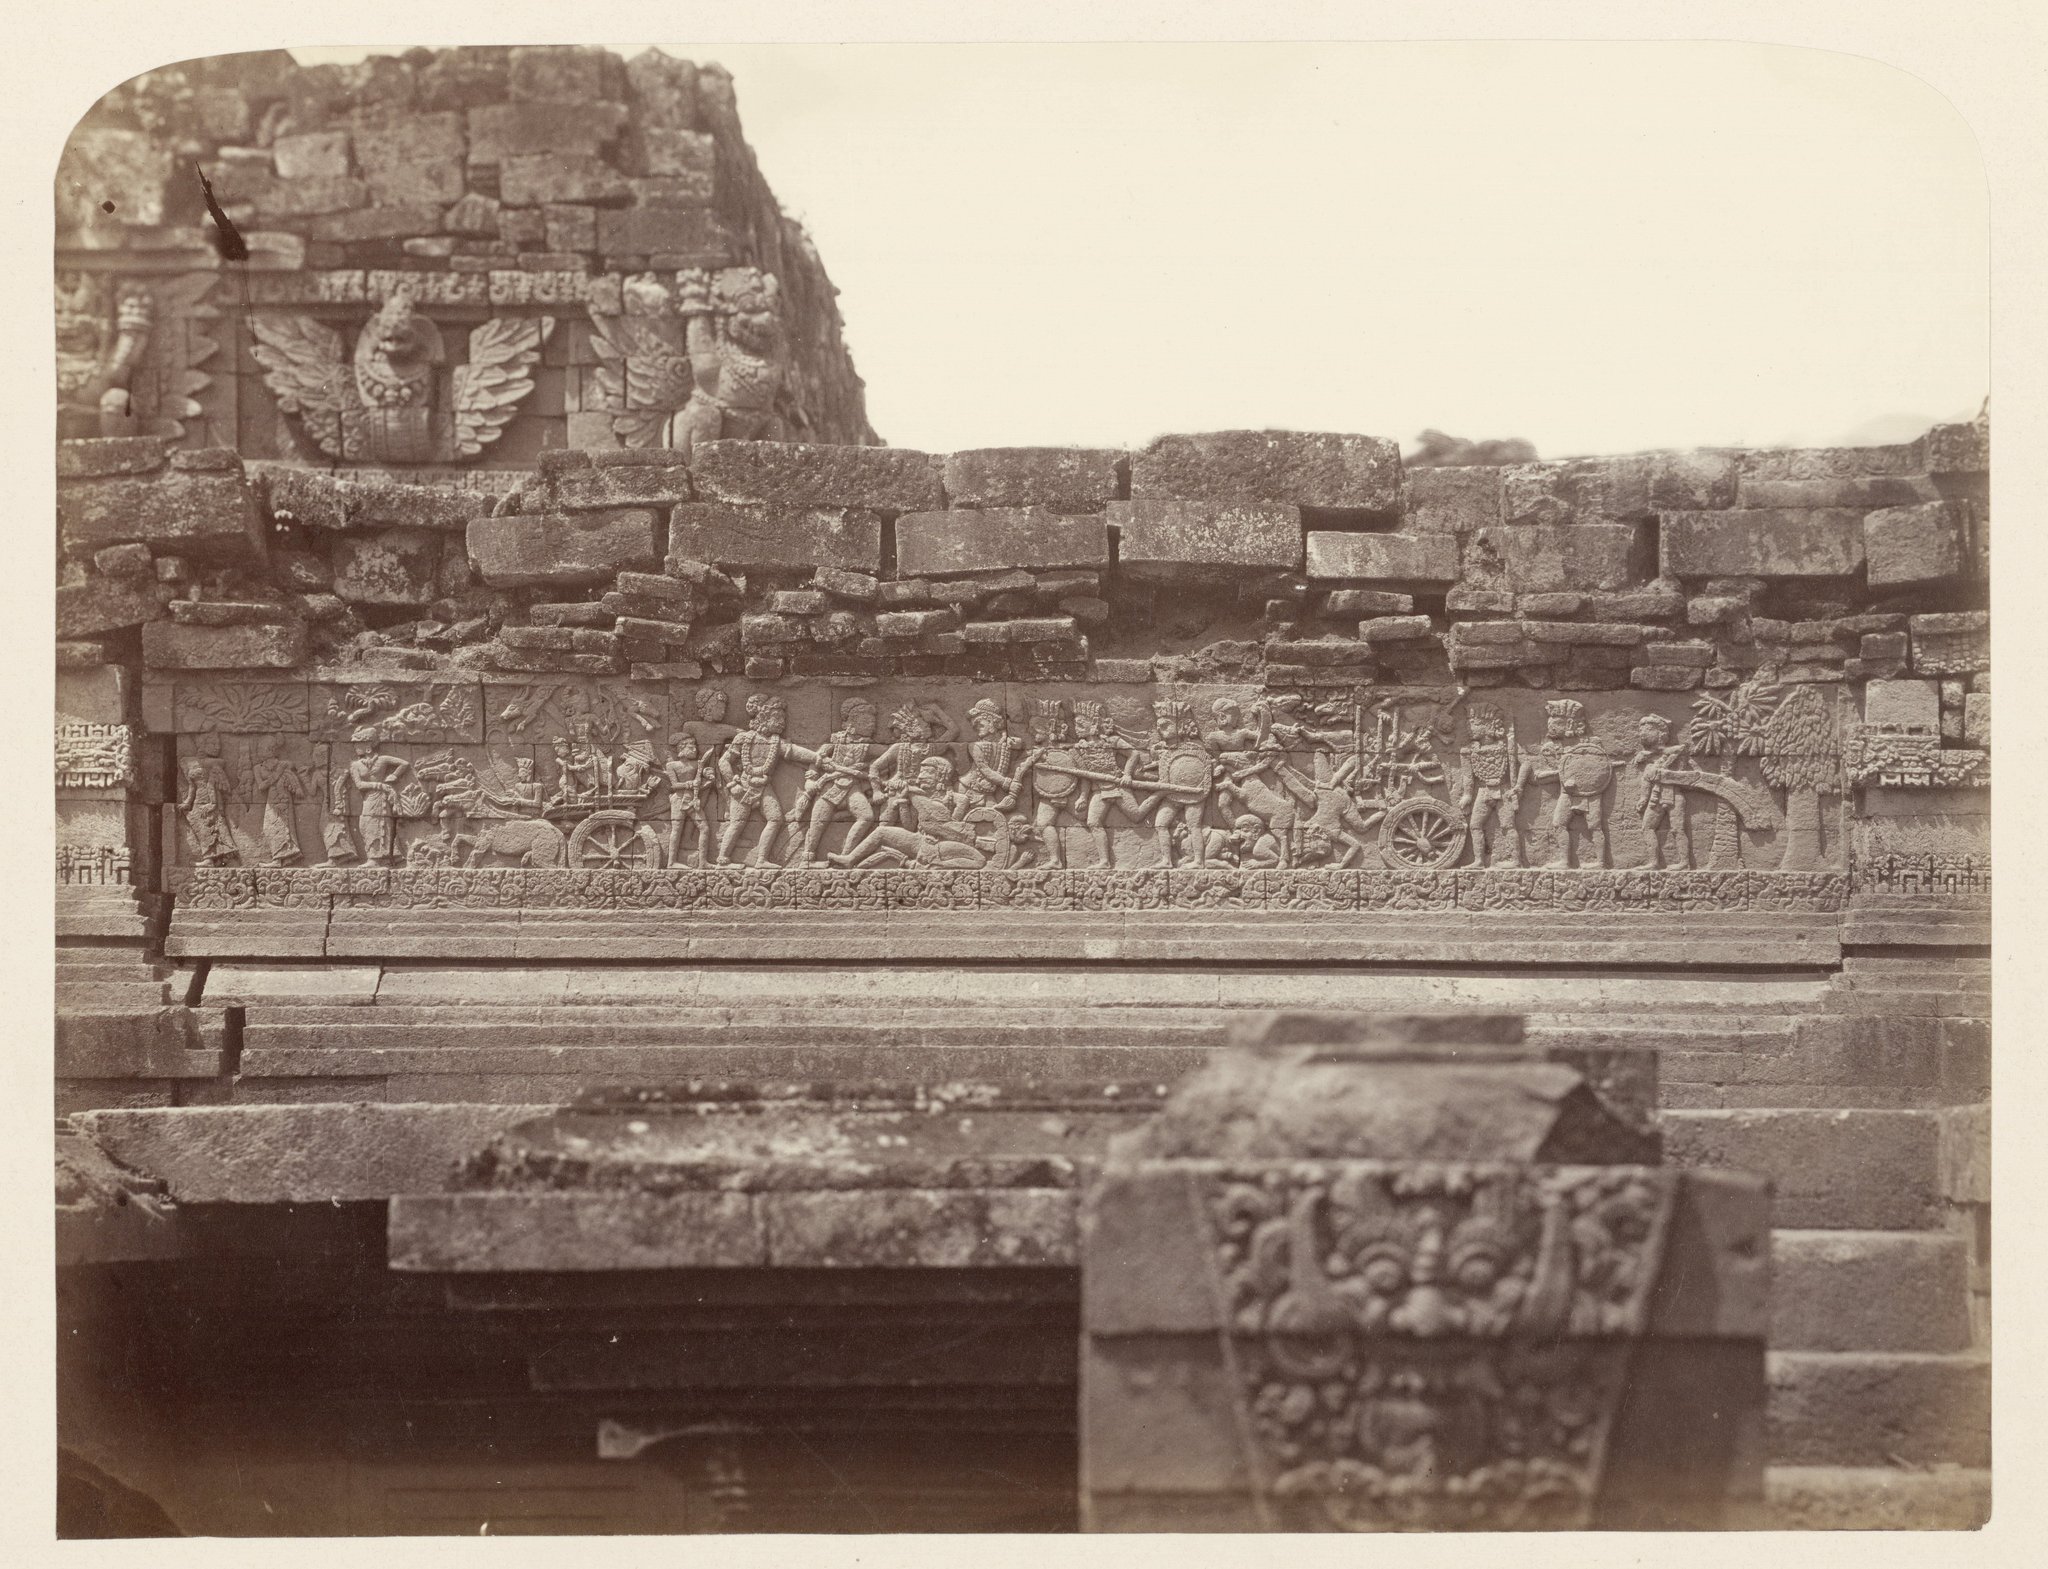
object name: photograph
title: Candi Panataran (temple Complex), Main Temple; Krishnayana relief no. 21 (the final battle in which Krishna is victorious), second narrative register, west side. Panataran, Blitar district, East Java province, 1323-1347 AD, Indonesia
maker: isidore kinsbergen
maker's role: fotograaf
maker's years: 1821-1905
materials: cardboard, paper, photographic support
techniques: albumen print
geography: java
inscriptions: title: ‘Basrelief van den tempel (voorzijde) 1e gaanderij te Panataran (Residentie Kediri) Cat. No. 255’, number: ‘80’